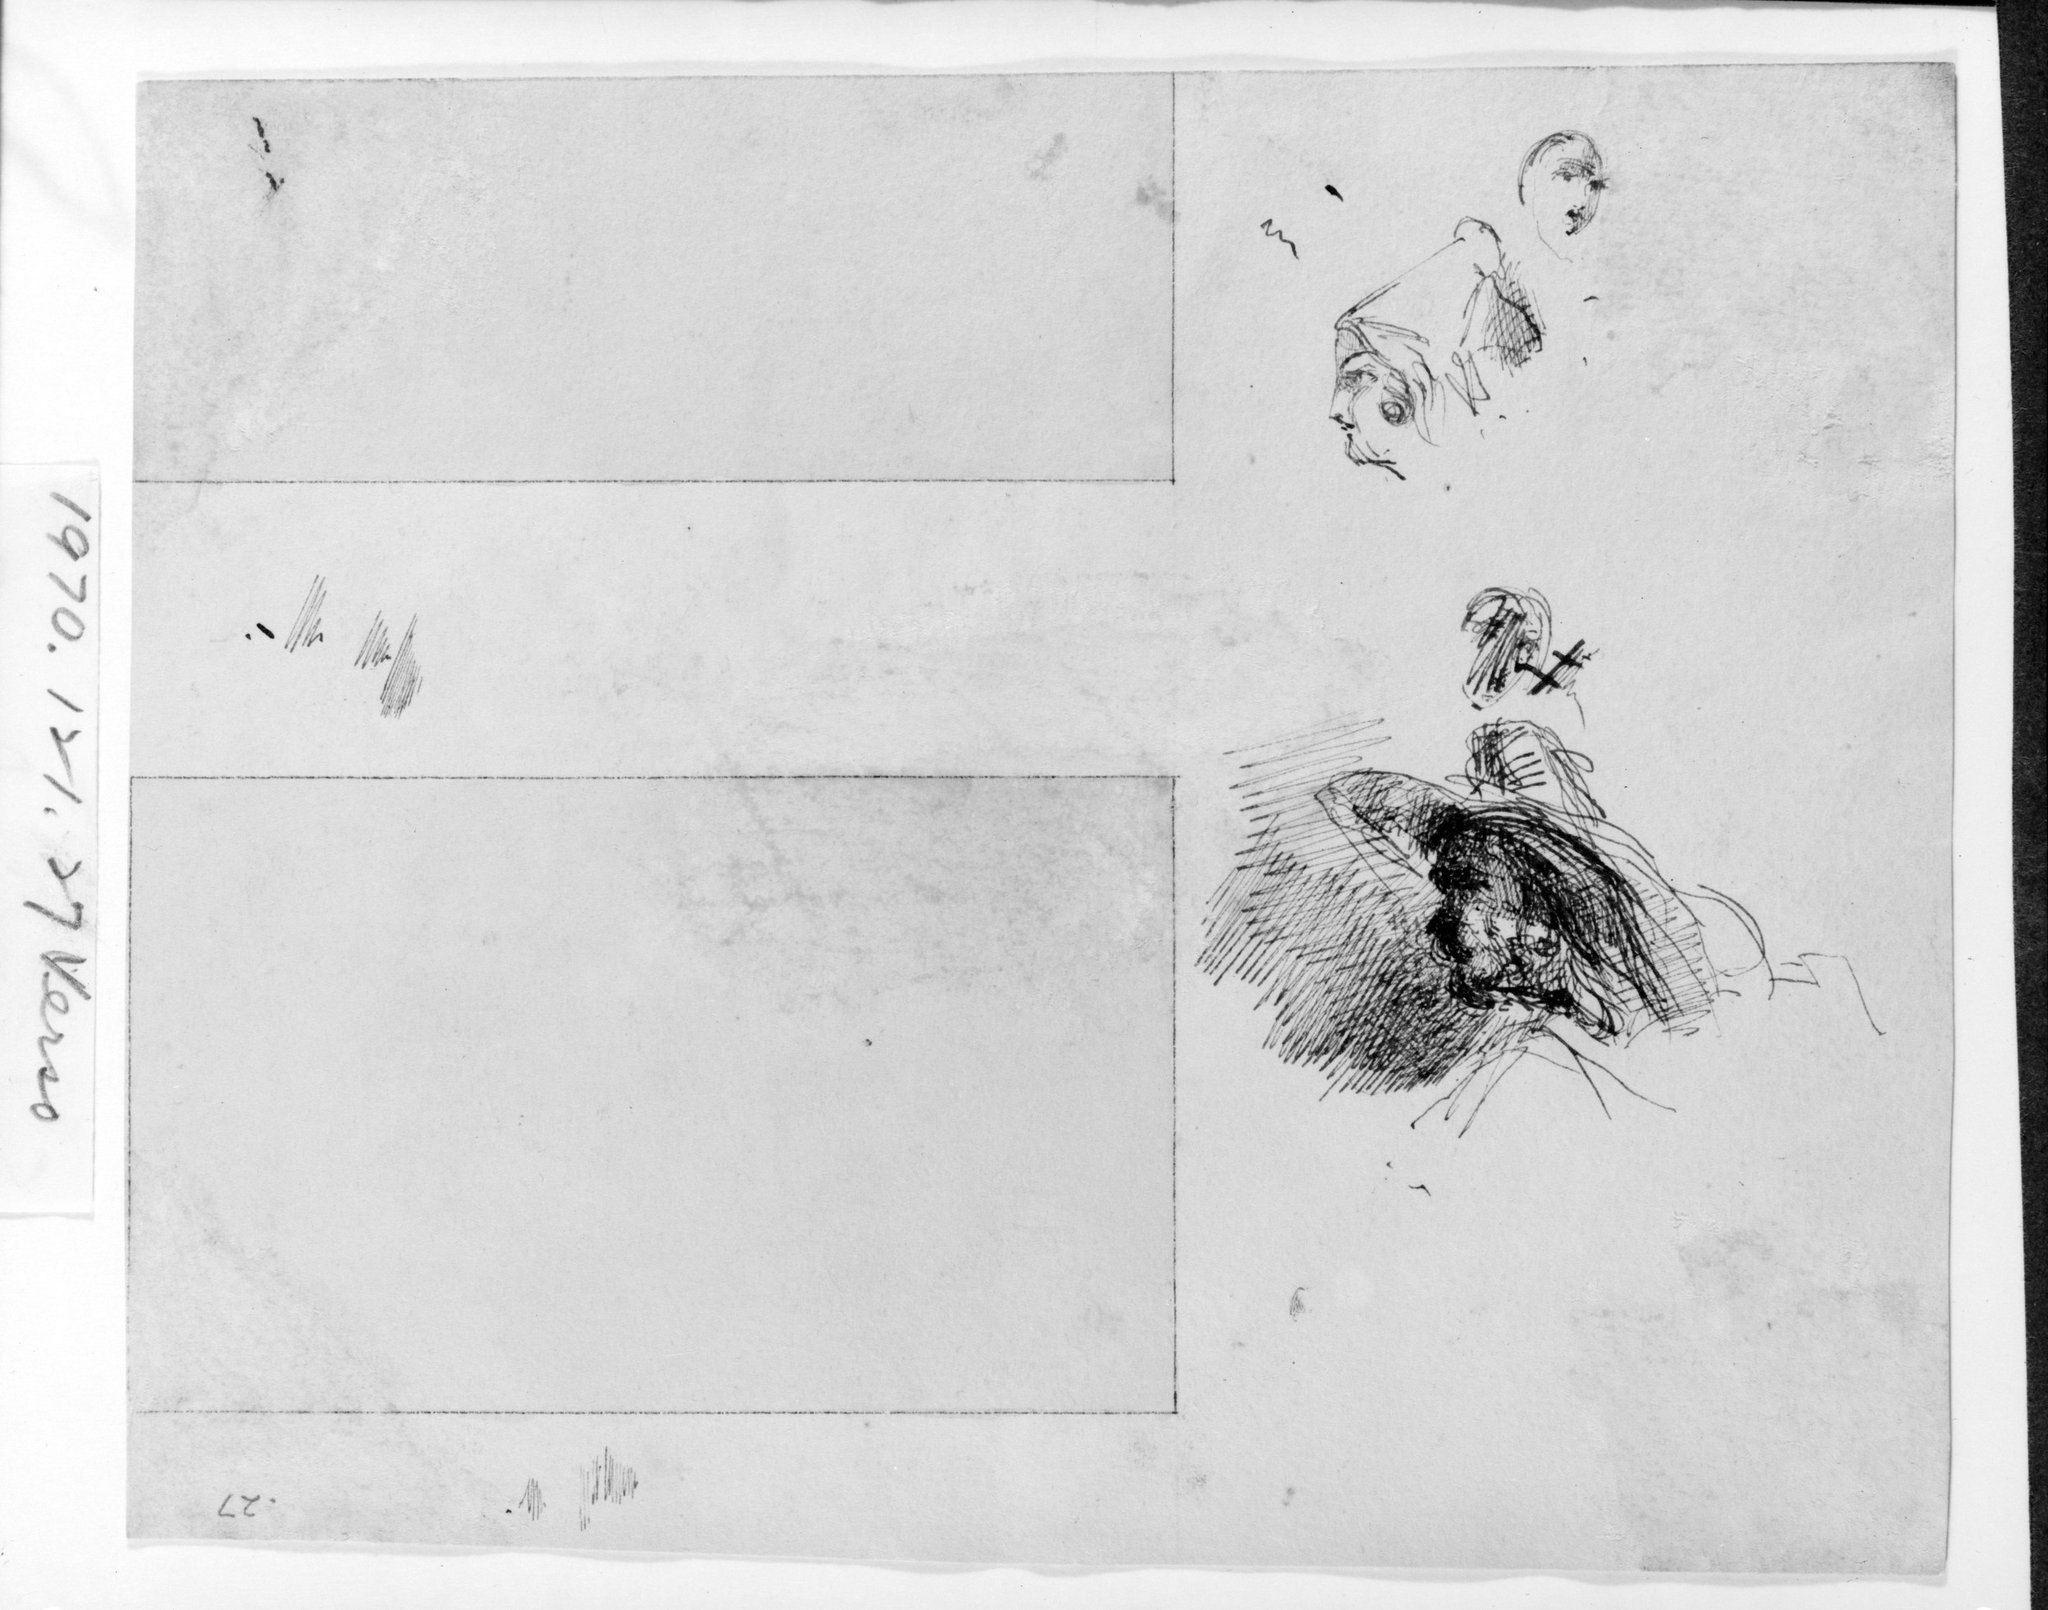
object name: drawing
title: Two Profile Studies; One Sketch of a Head (from Sketchbook)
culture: american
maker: james mcneill whistler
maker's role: artist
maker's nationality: american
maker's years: 1834-1903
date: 1854-1855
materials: ink, paper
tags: heads,profiles